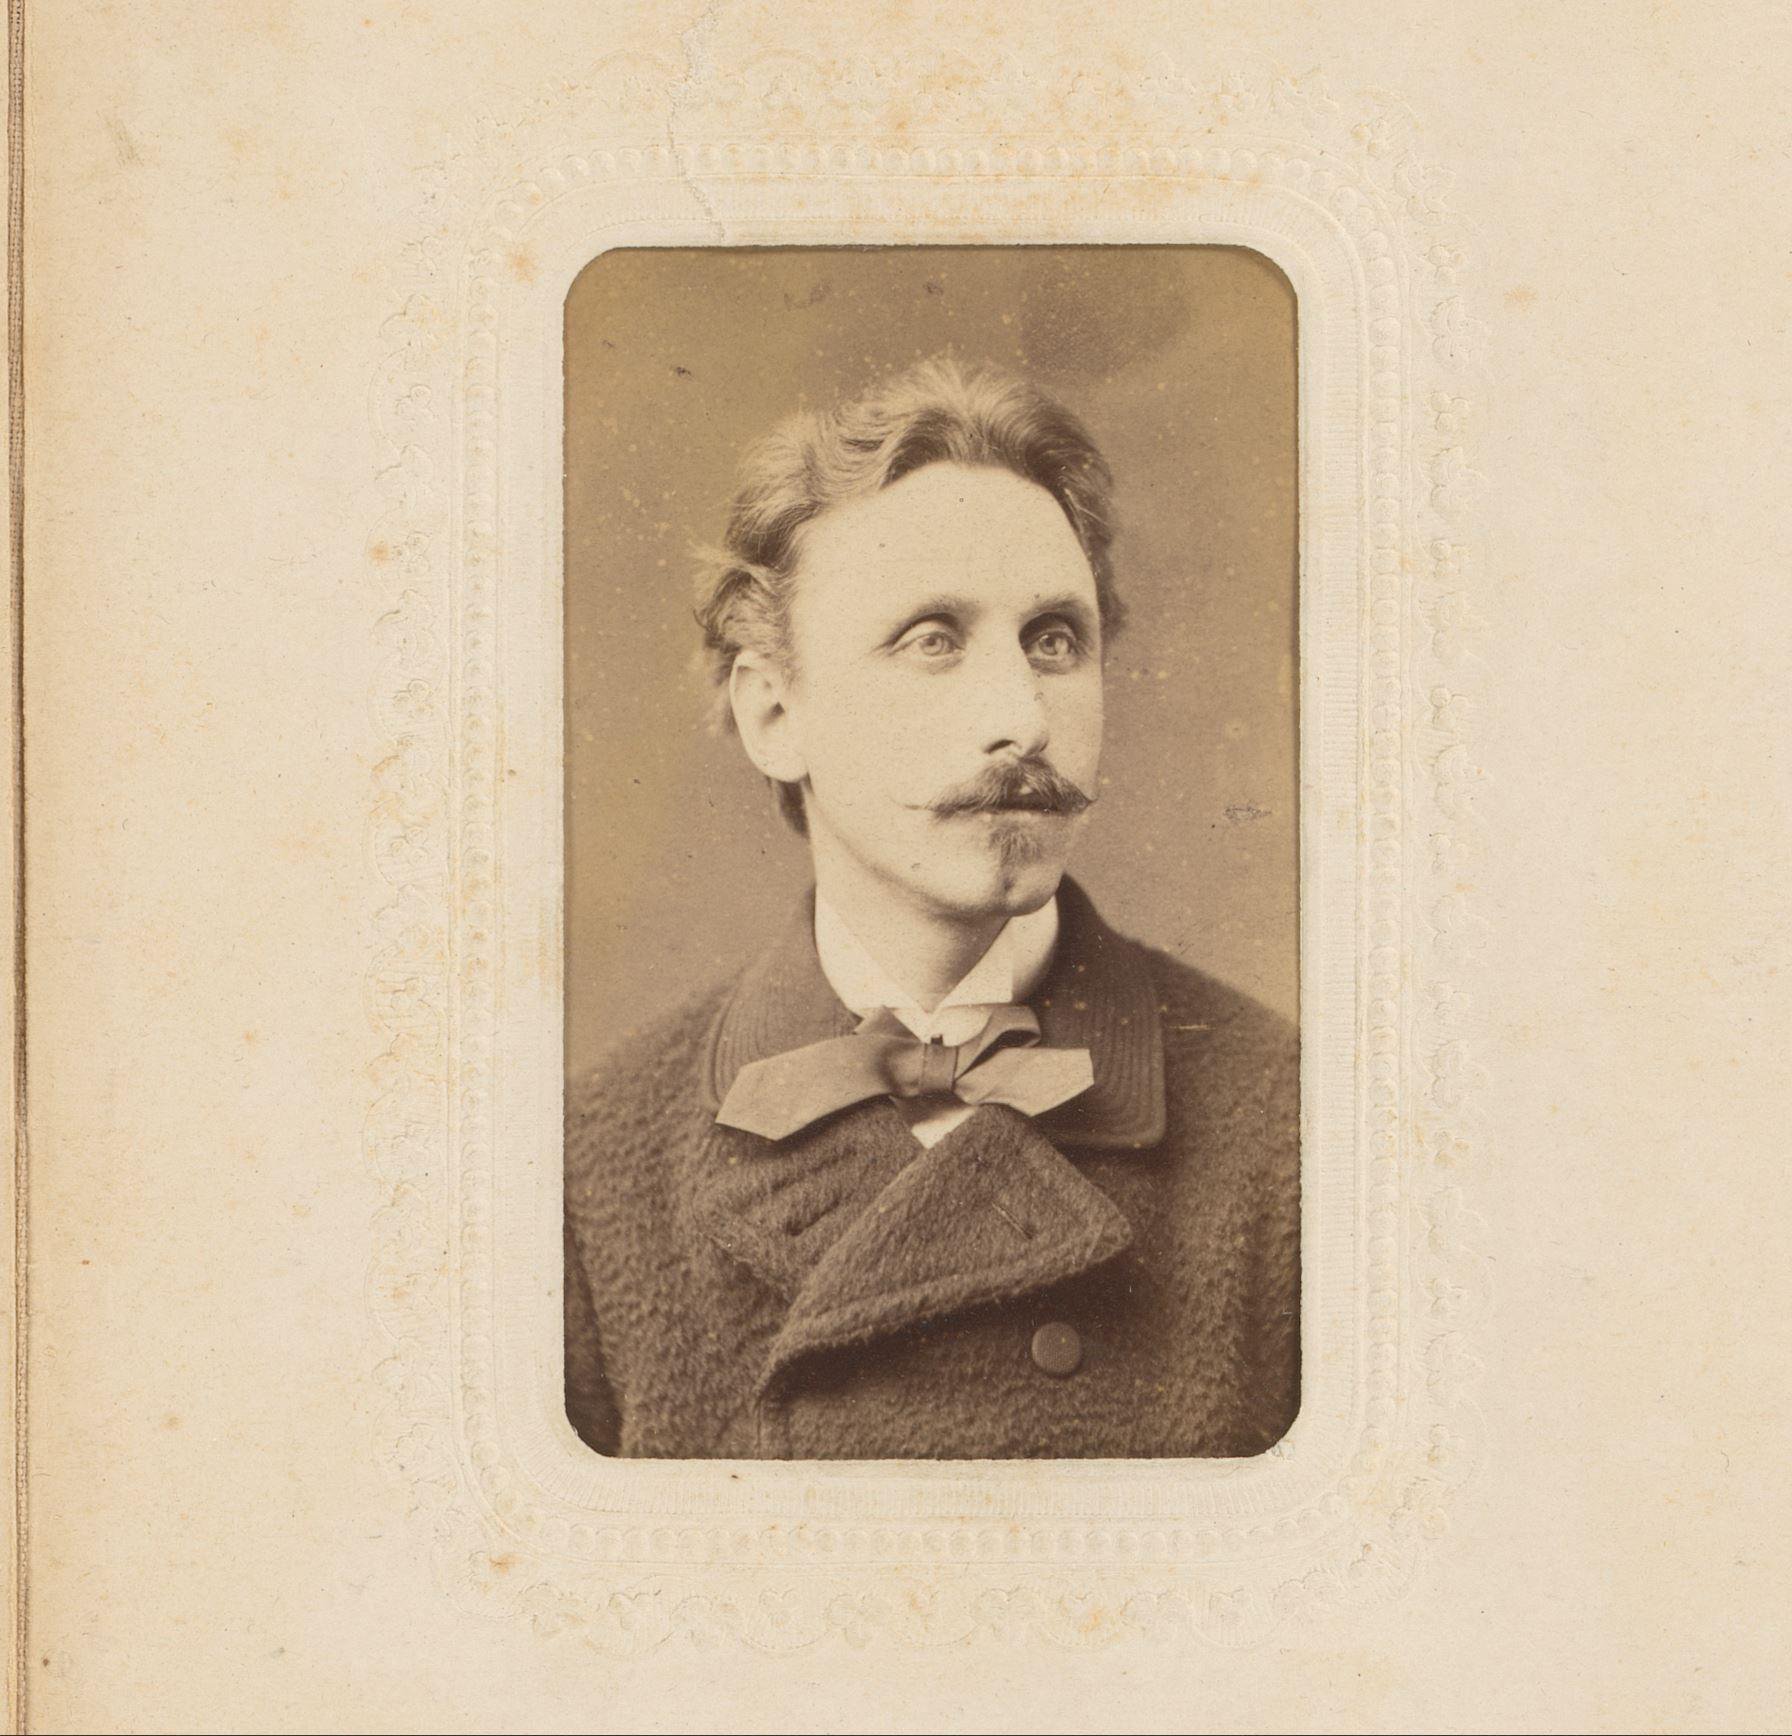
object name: photograph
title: Portret van een man met snor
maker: eugene guérin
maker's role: fotograaf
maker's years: 1845-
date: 1871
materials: cardboard, photographic support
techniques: albumen print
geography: brussels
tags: moustache, historical persons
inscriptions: inscription: ‘Guérin/ Bruxelles/ 32, Rue de Louvain’, inscription: ‘Eugène Guérin/ Bruxelles’, annotation: ‘A mon bonne ami Louis/ Souvenir tot affectueux/ Bruxelles 15/4 71/ [...]’